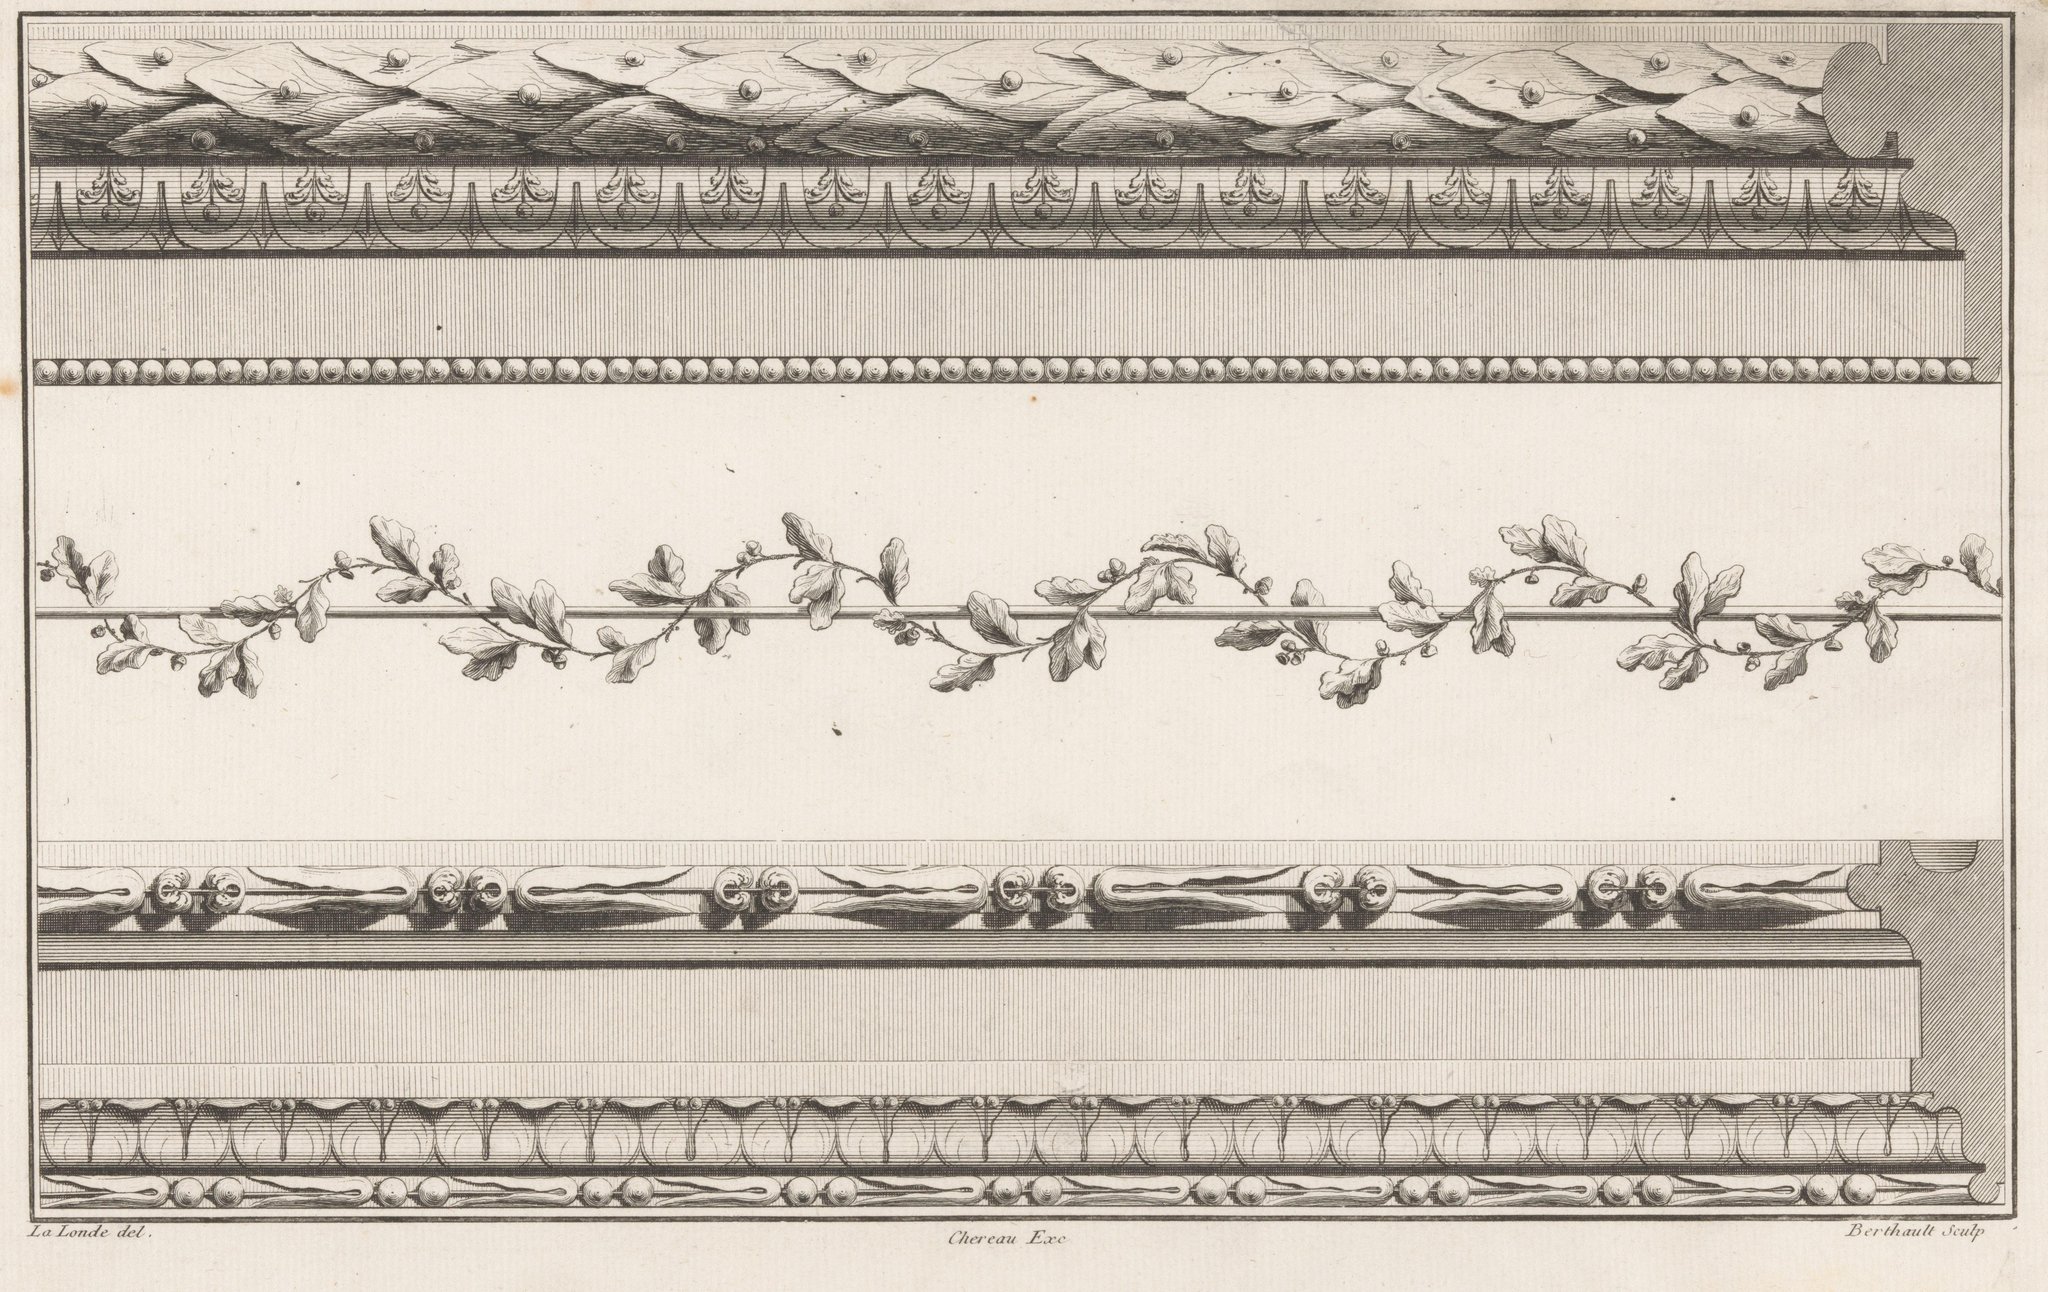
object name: ornament print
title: A Cahier de Bordures à l'usage de la Sculpture &c, avec leurs Profils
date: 1784-1785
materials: paper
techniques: engraving, etching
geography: paris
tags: ornaments ~ art (+ framing decorations)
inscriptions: collector's mark: Lugt 2228, collector's mark: Lugt 2760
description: Een lijst met bladmotieven, een lijst met een rank van eikenbladeren en een lijst met tulpen en bladmotieven.